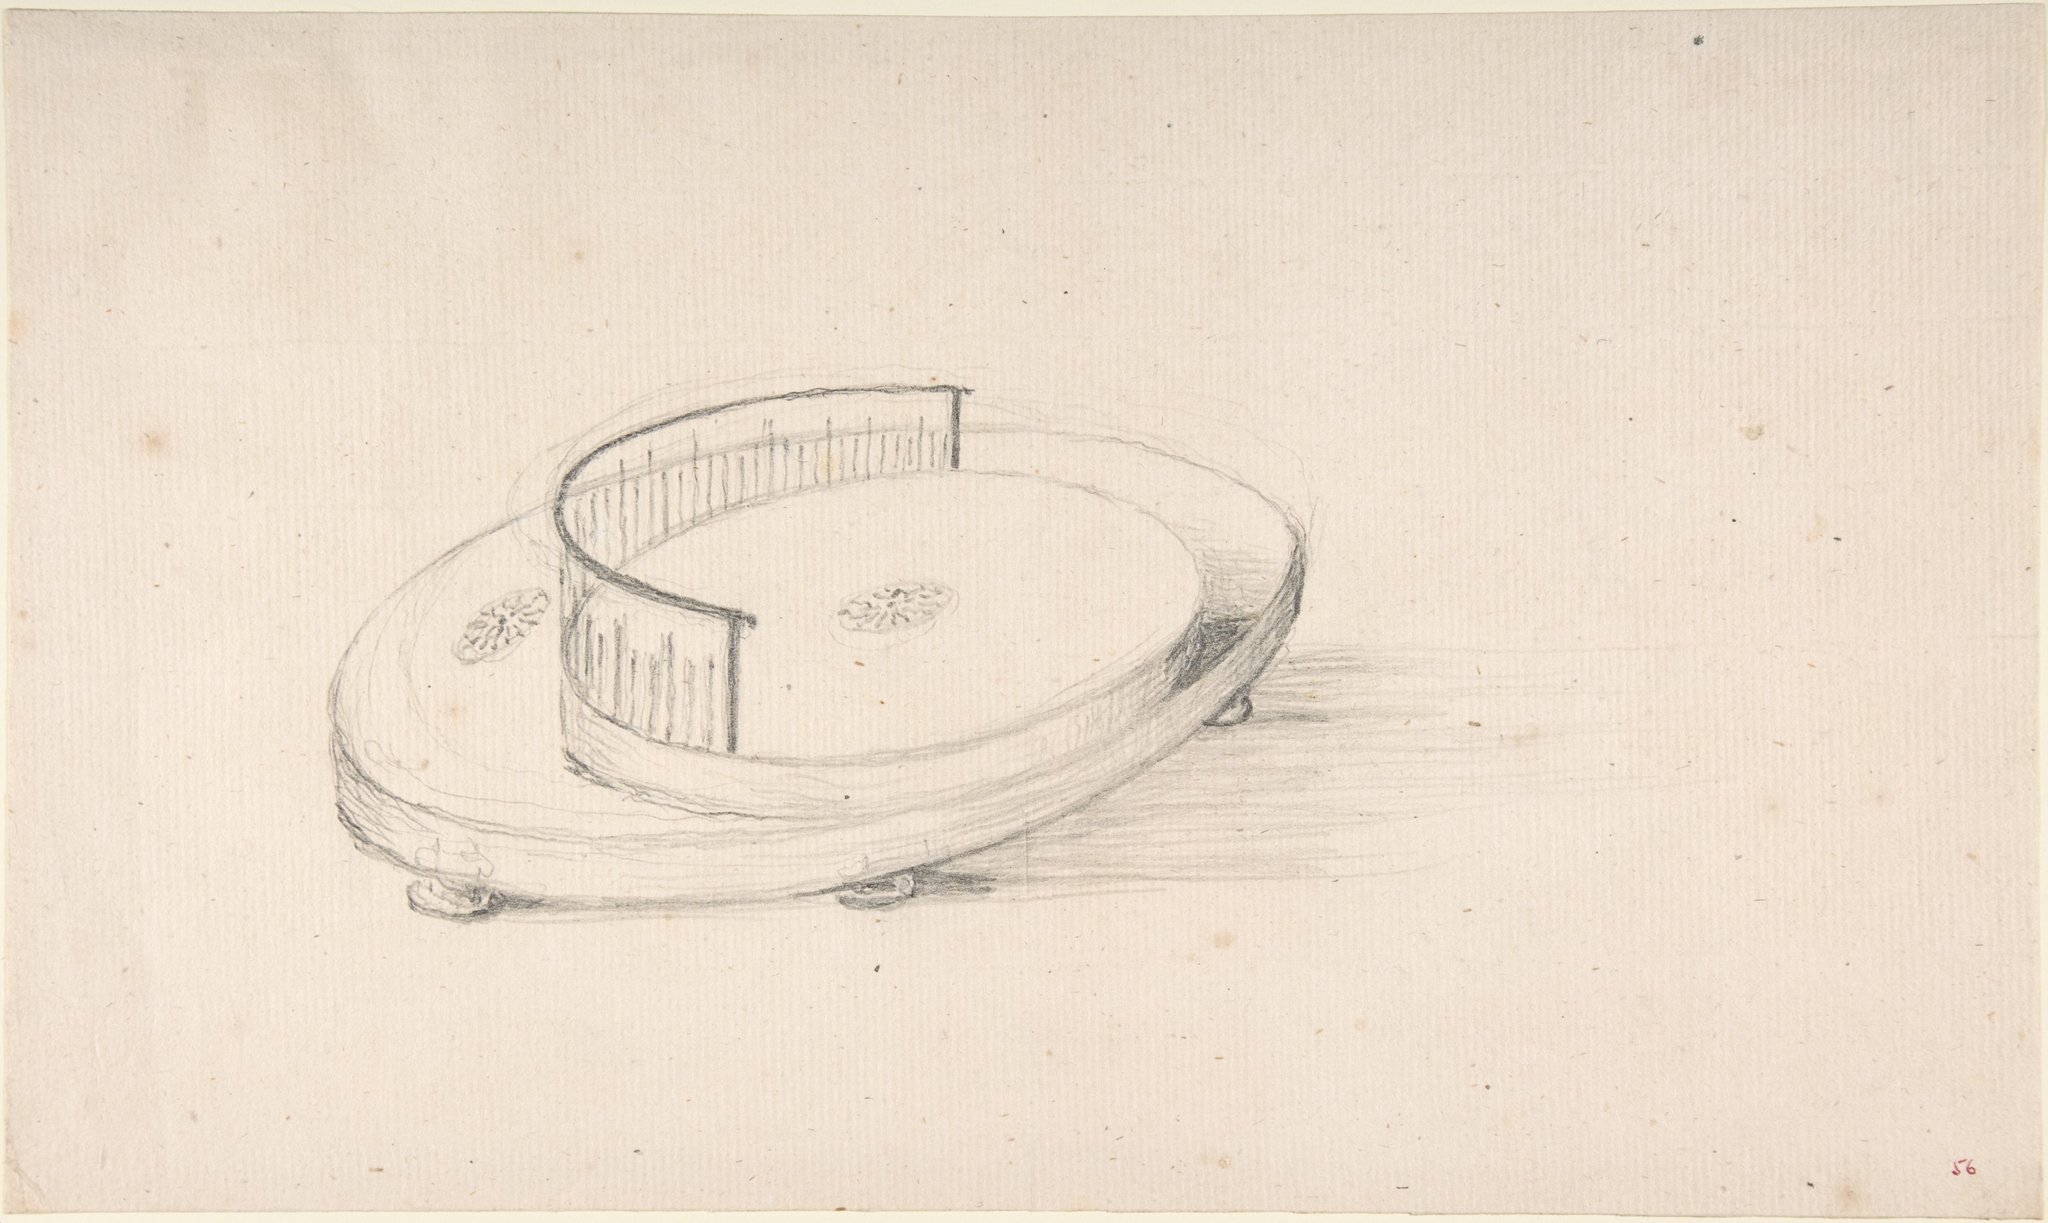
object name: drawing ornament architecture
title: Design for an Oval Serving Dish with Circular Raised Platform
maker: anonymous, french, 18th century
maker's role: artist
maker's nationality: french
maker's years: 1700-1800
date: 1770-1790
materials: chalk